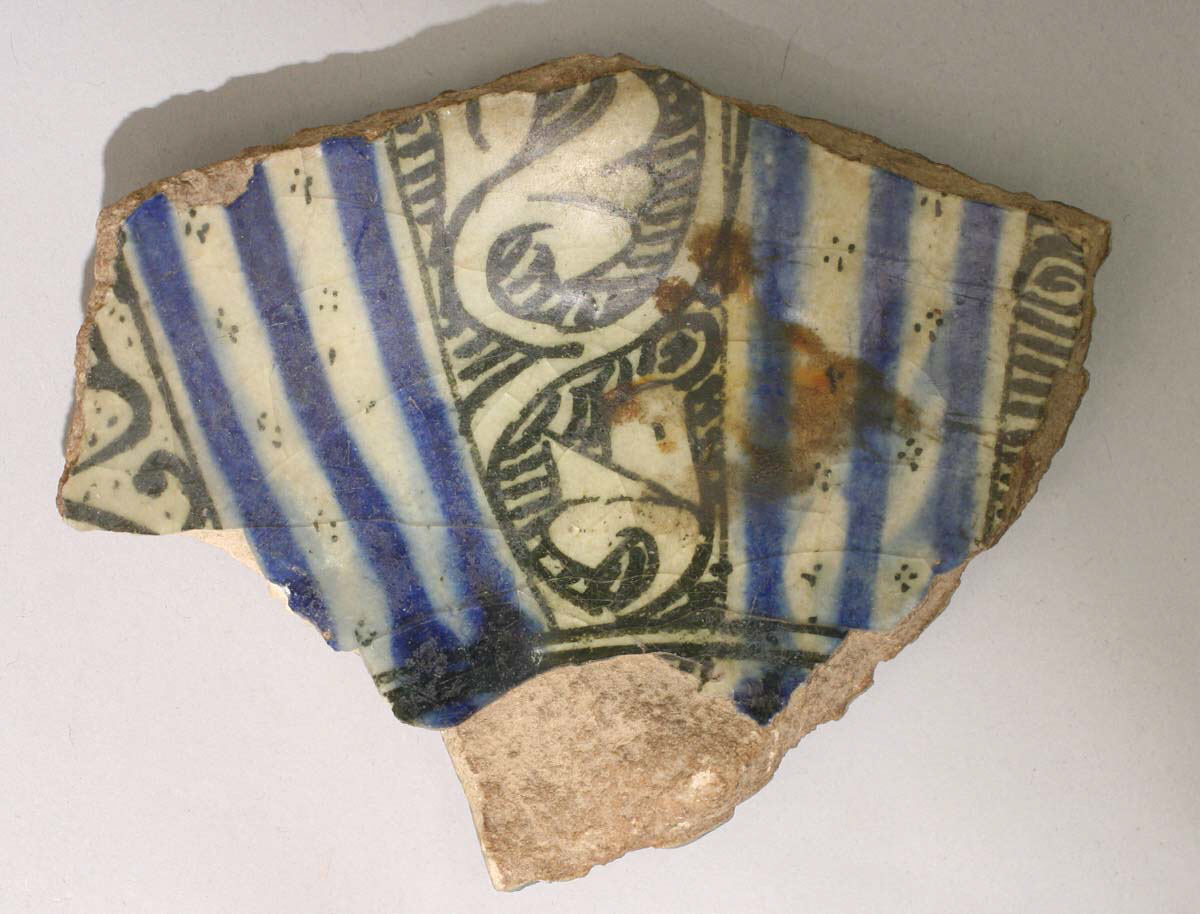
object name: fragment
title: Ceramic Fragment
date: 1301-1400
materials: stonepaste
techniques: painting, underglaze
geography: syria